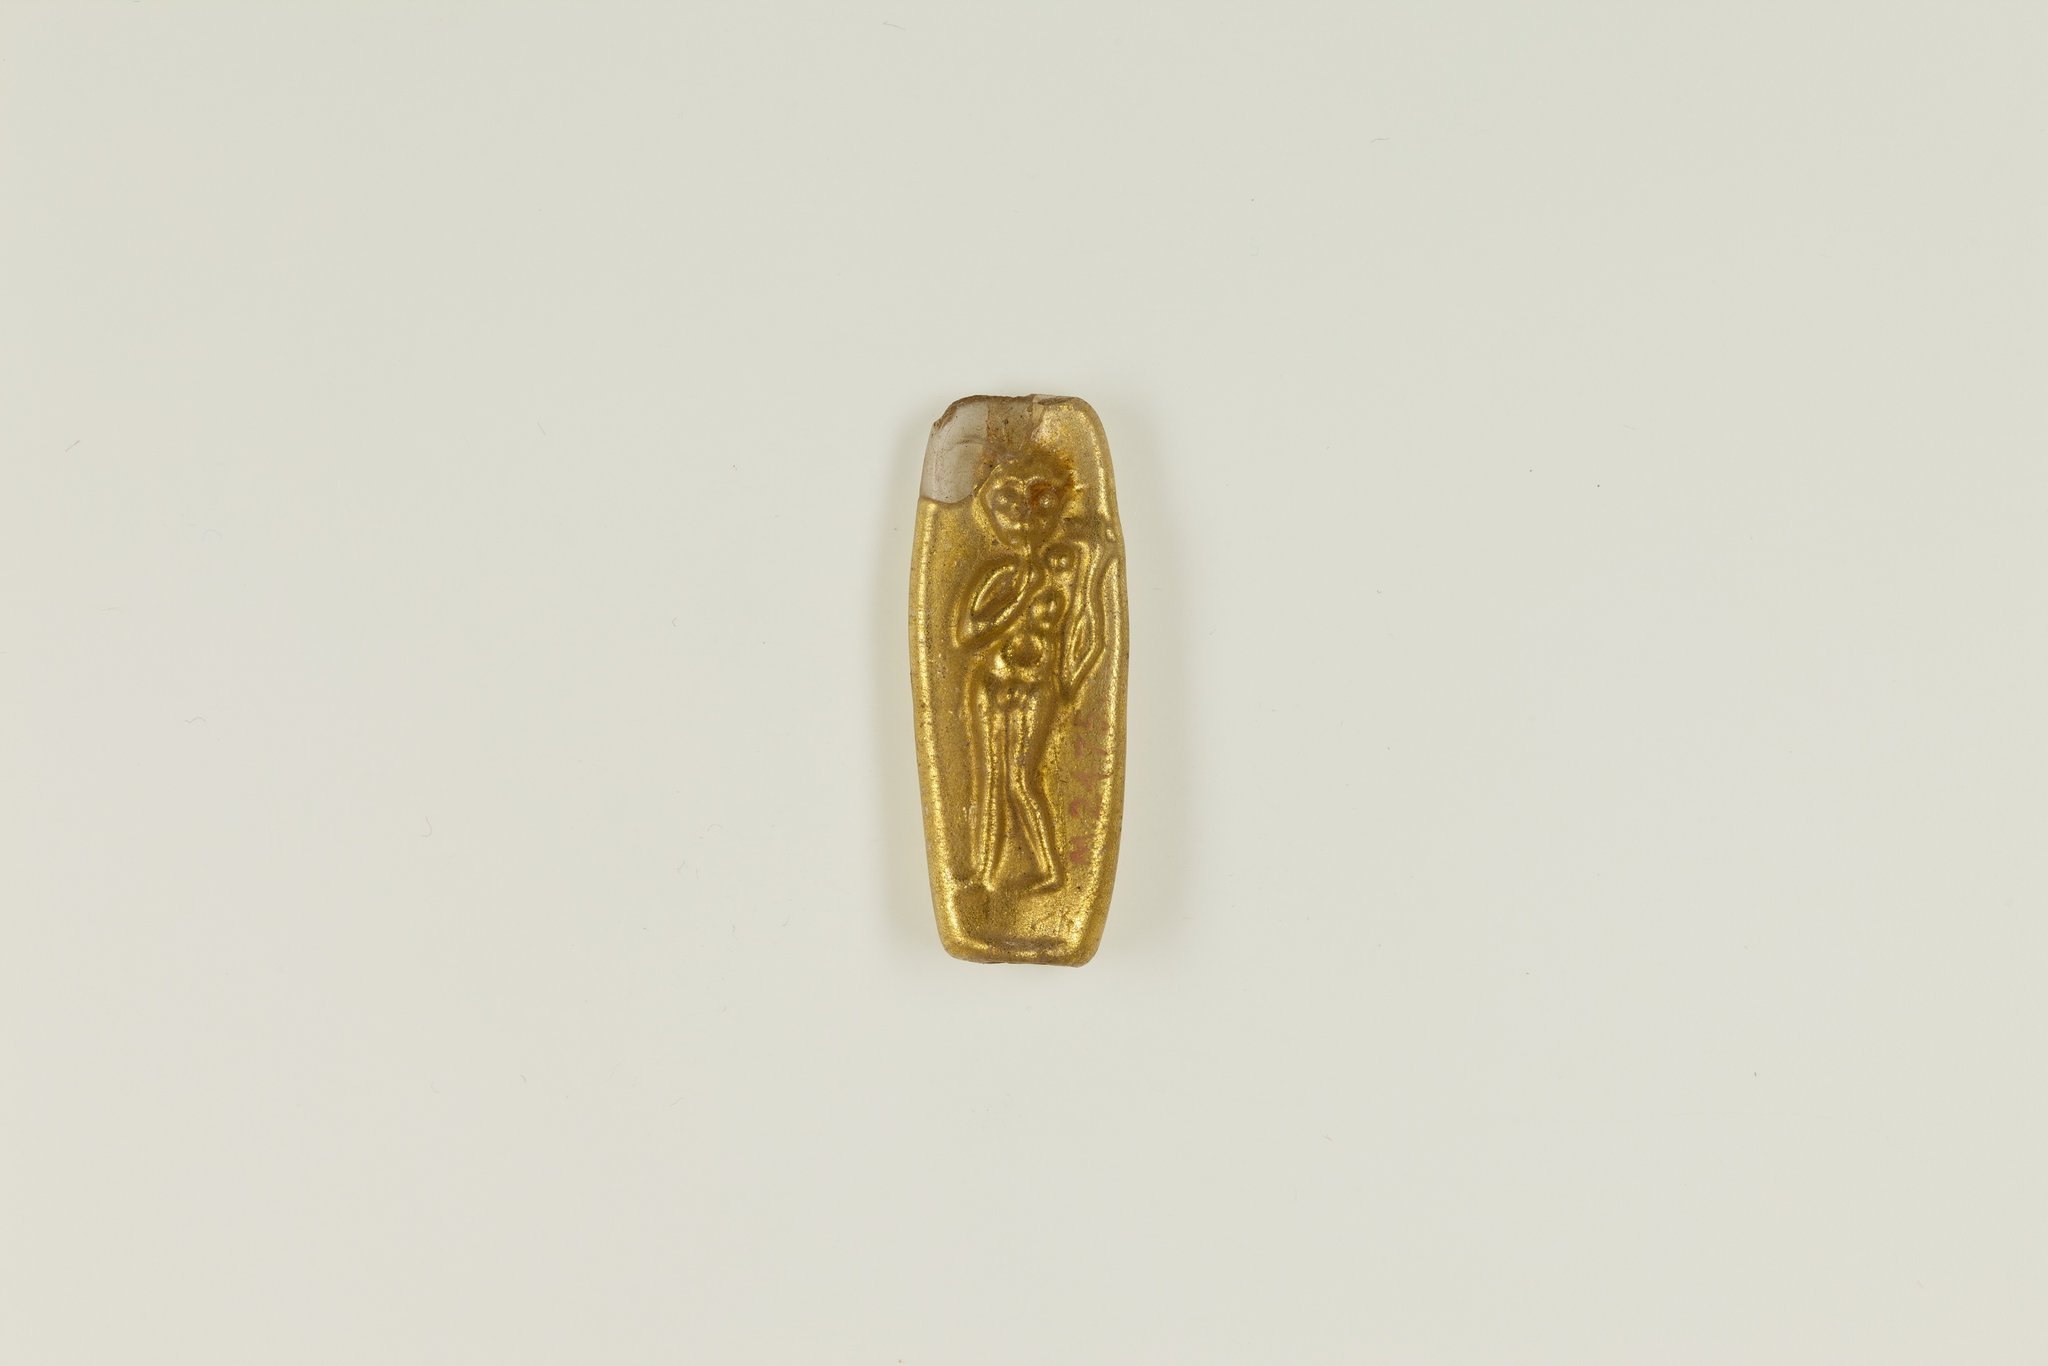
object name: amulet, harpokrates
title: Bead with figure of Harpokrates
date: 100 BCE-100 CE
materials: glass, gold foil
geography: egypt